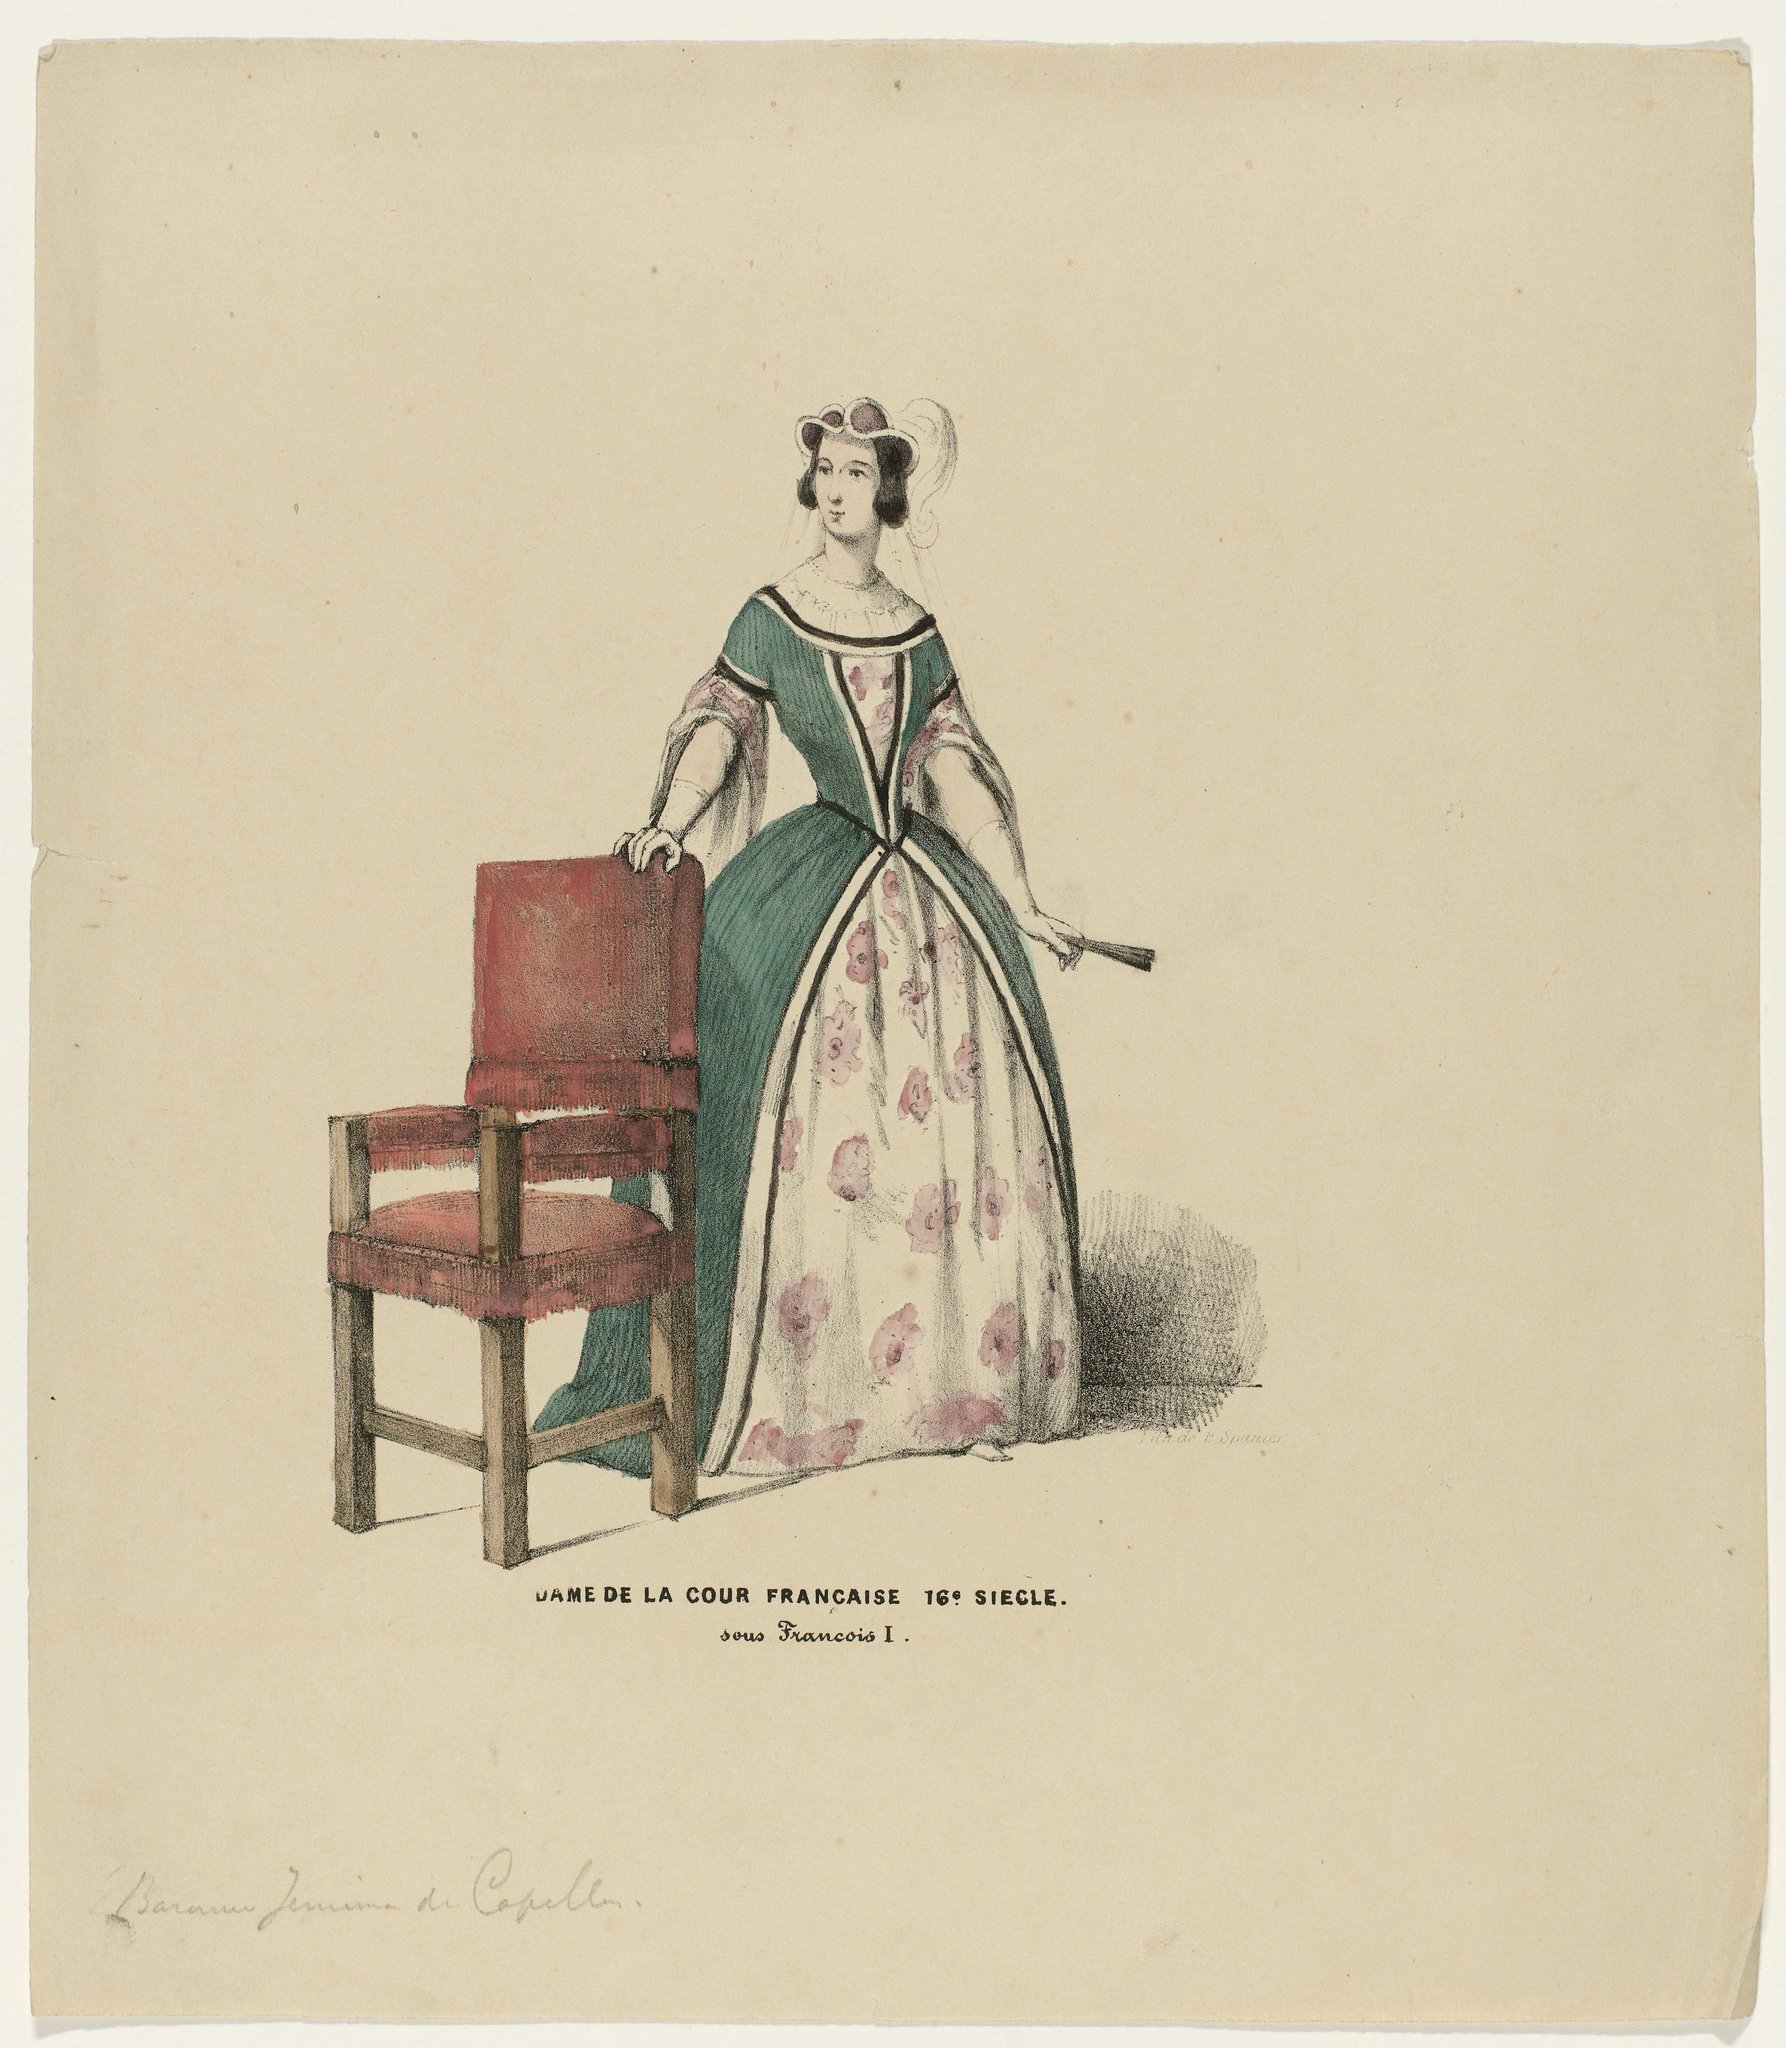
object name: costume print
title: Dame de la Cour Francaise 16e Siècle. sous Francois I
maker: elias spanier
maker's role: print maker, printer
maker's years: 1821-1863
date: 1840-1850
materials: paper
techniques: hand coloring, lithograph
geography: the hague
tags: historical costume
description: Vrouw in historisch kostuum van een hofdame aan het Franse hof van Frans I, 16e eeuw. Voorstelling toegevoegd aan het plaatwerk over het gekostumeerd bal gehouden op het paleis van de prins van Oranje (de latere koning Willem III) in Den Haag op 26 februari 1845.